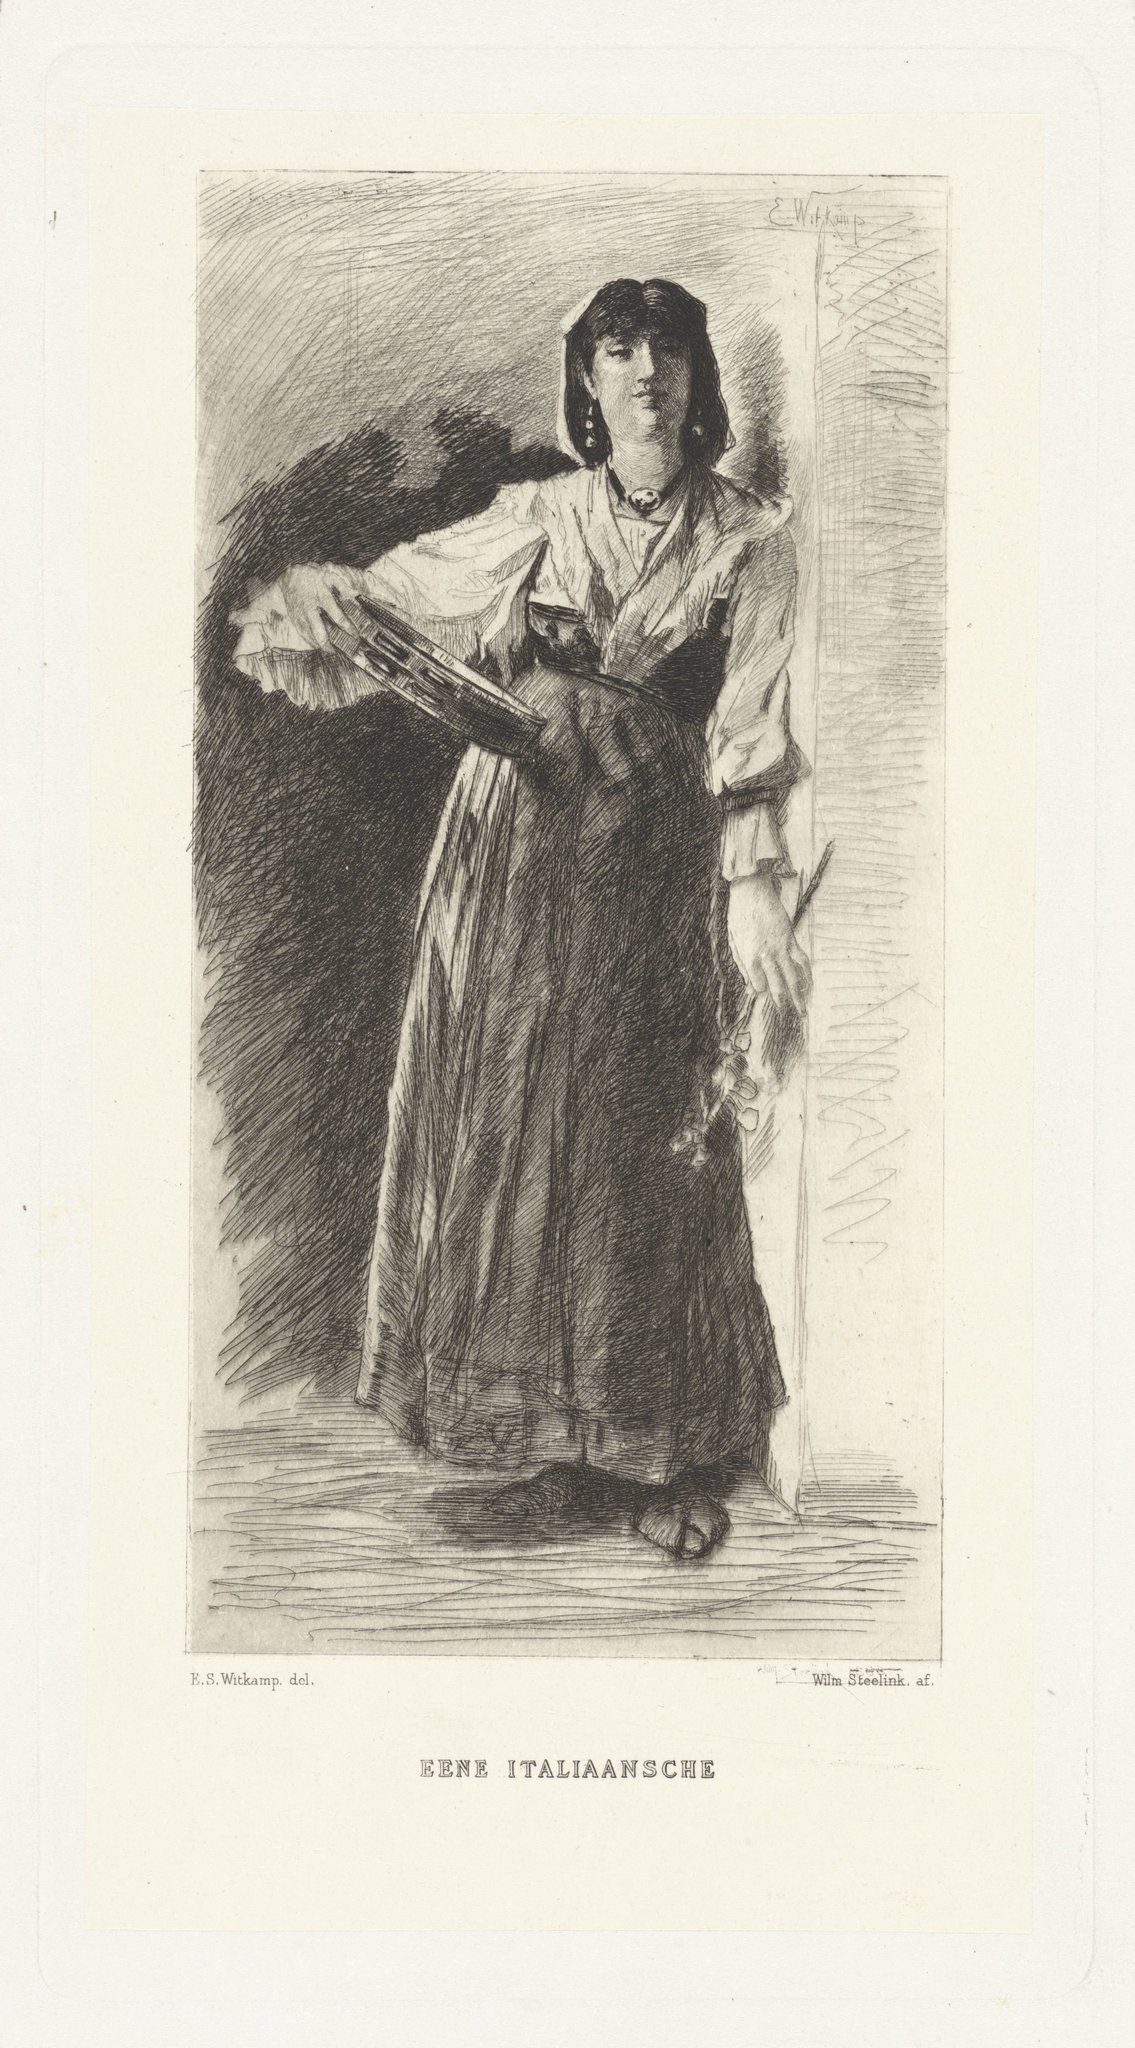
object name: print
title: Eene Italiaansche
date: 1888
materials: paper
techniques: etching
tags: tambourine, standing figure - aa - female human figure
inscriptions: collector's mark: Lugt 2228